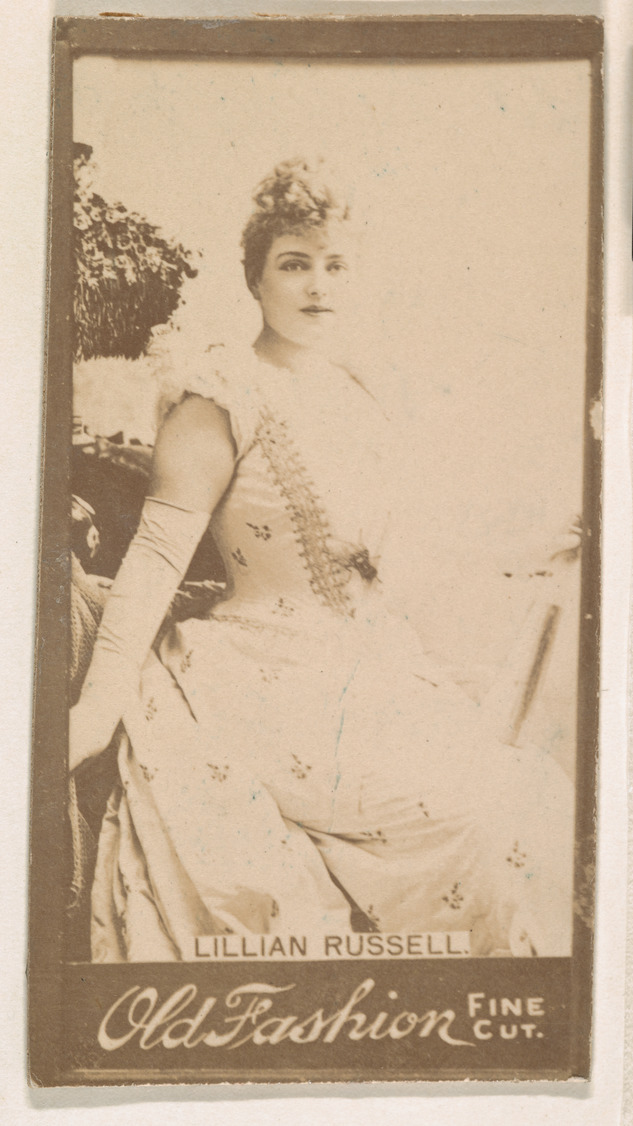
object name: photograph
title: Lillian Russell, from the Actresses series (N664) promoting Old Fashion Fine Cut Tobacco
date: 1888-1890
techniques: albumen silver print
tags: portraits,women,actresses